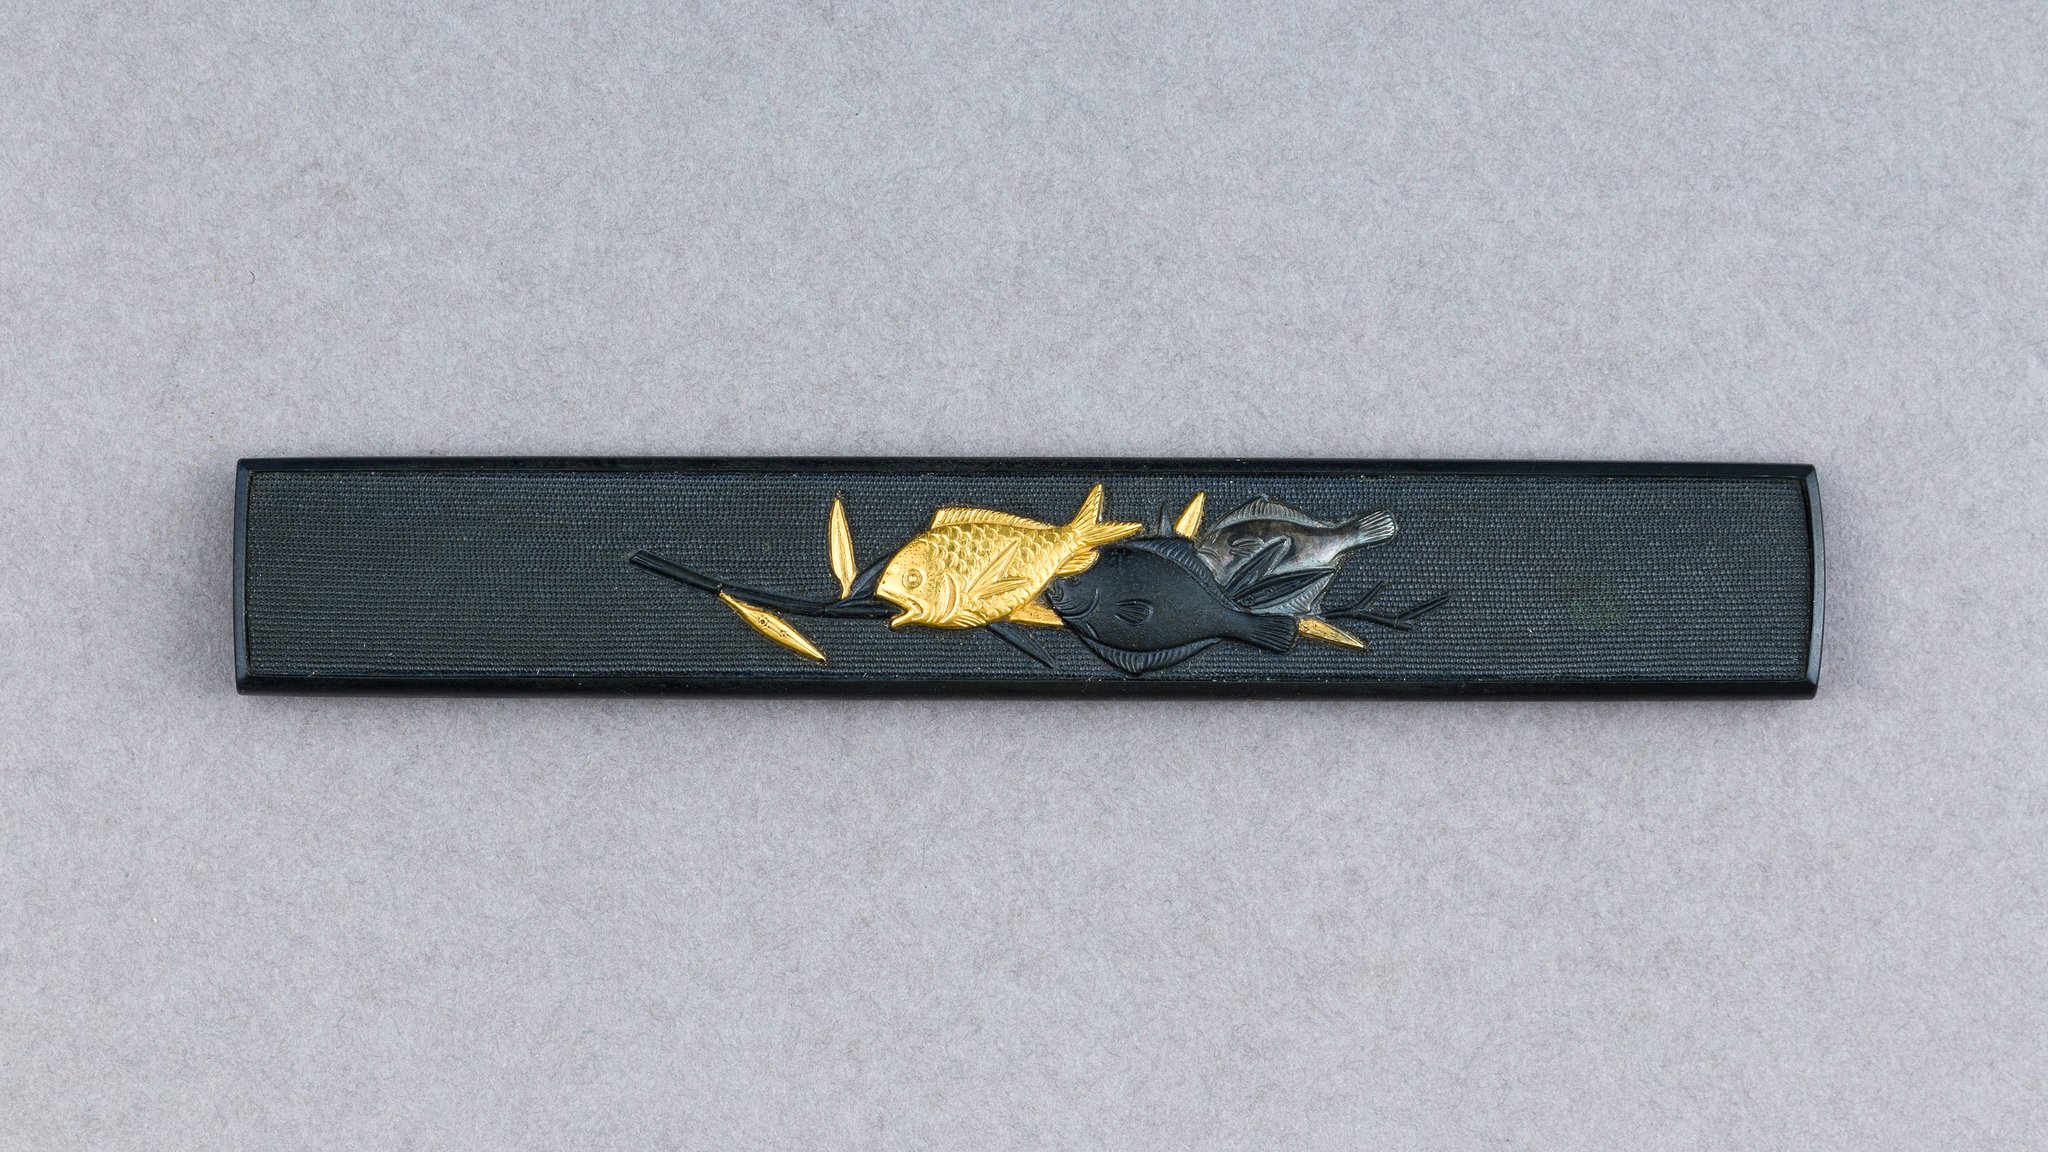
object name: knife handle kozuka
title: Knife Handle (Kozuka)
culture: japanese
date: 1615-1868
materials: gold alloy, gold, silver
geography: japan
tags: fish